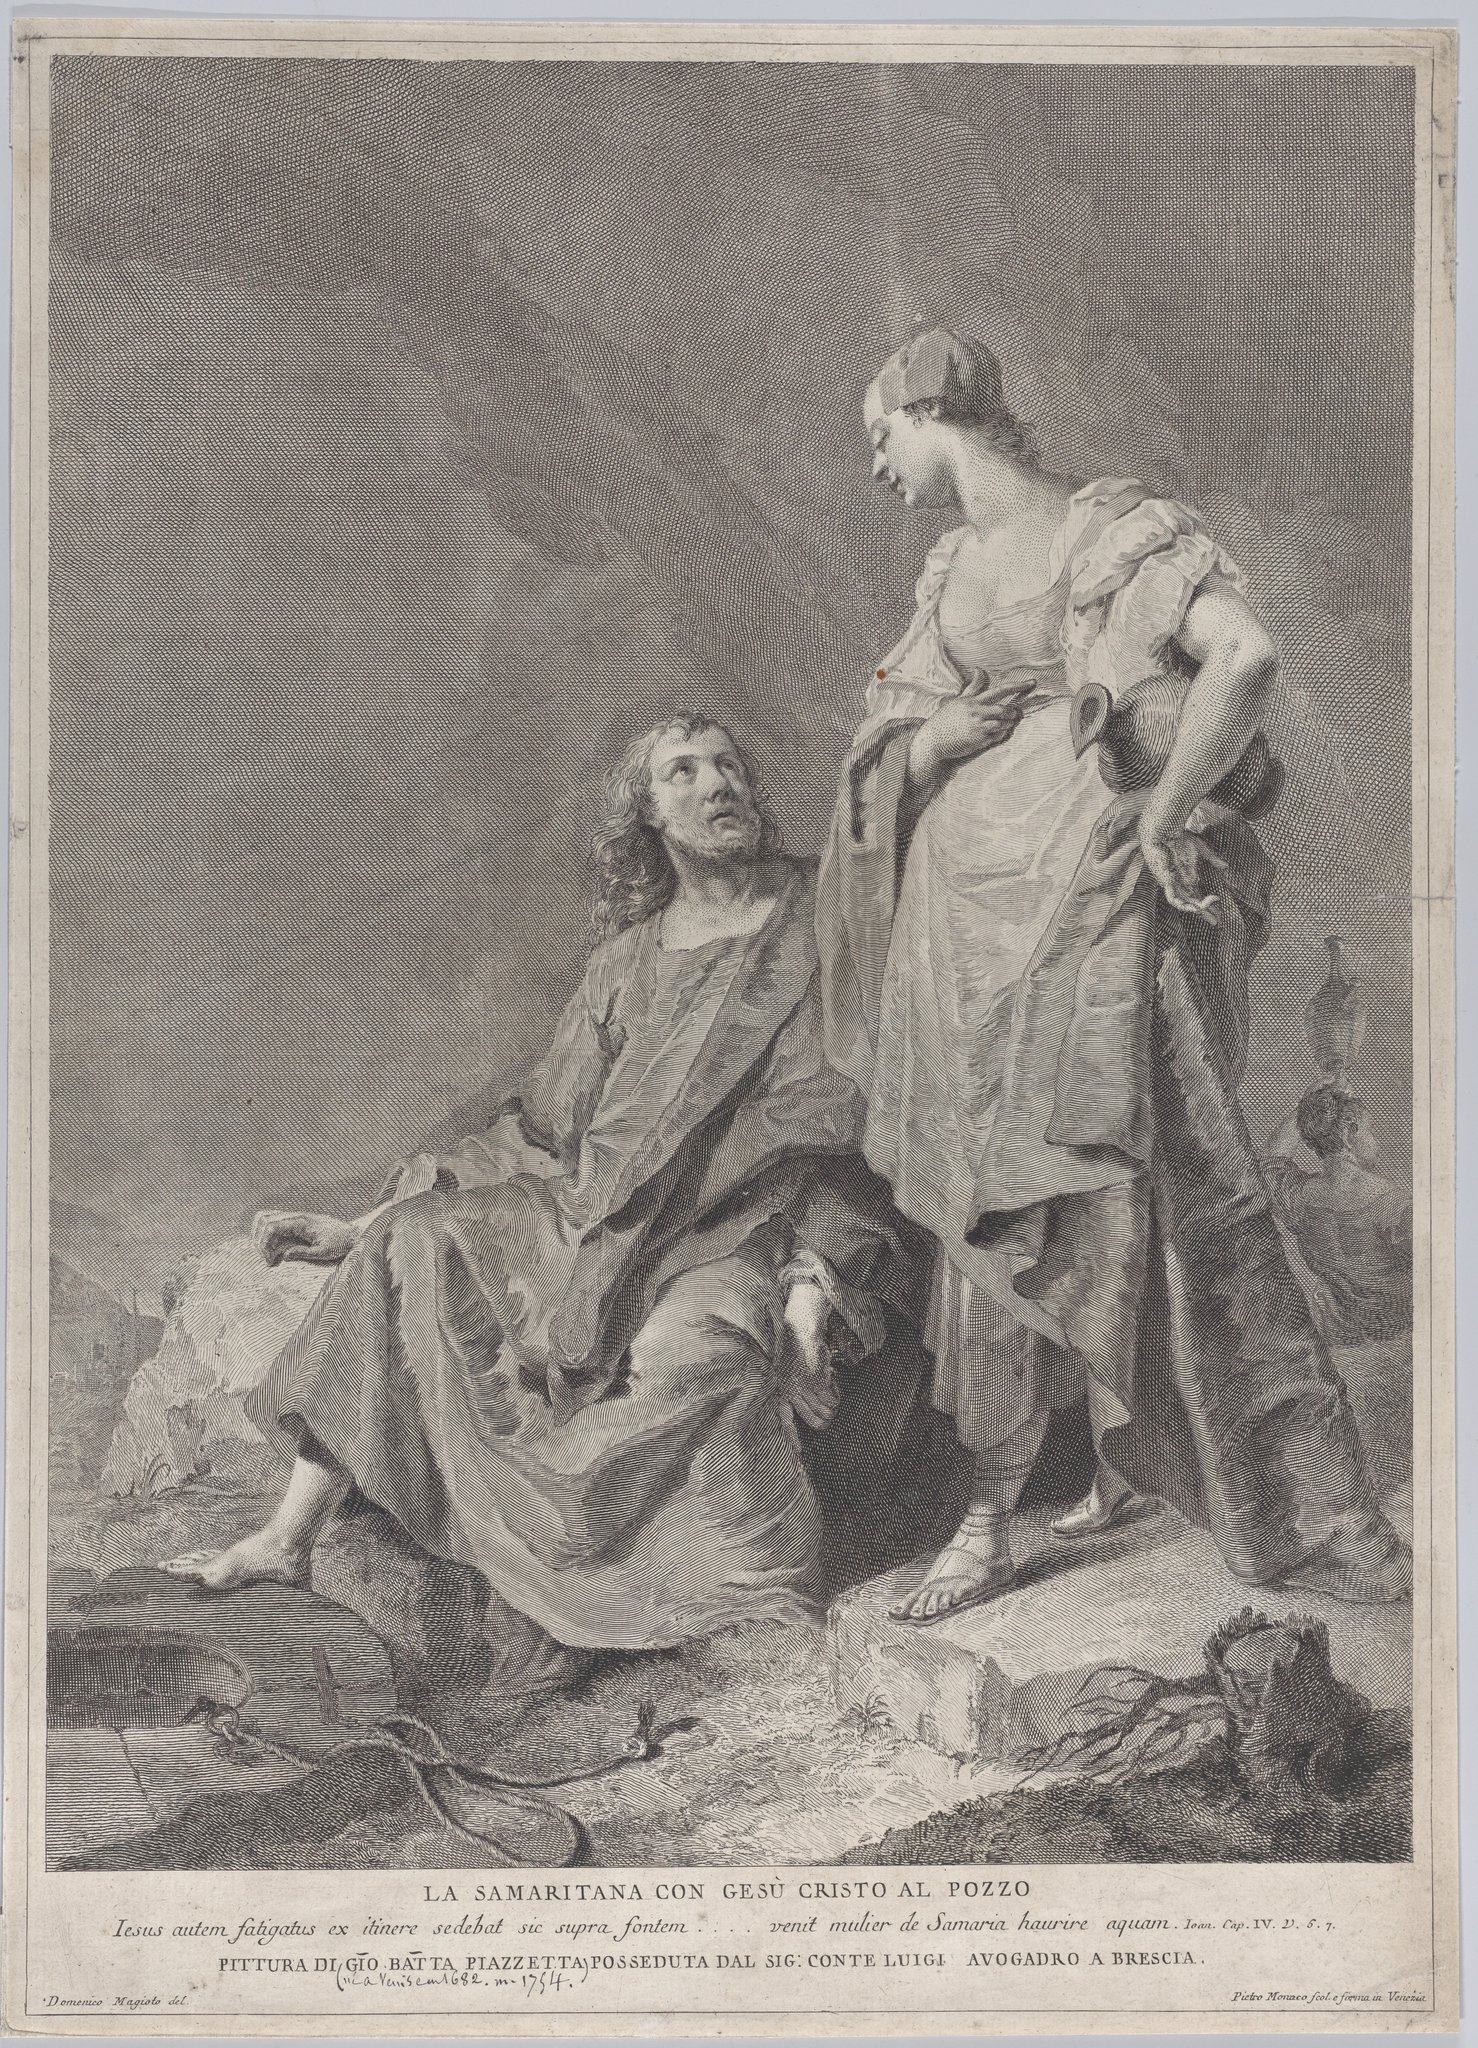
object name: print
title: Christ and the woman of Samaria at the well, from the series of 112 prints of the sacred history, after the painting by Giovanni Battista Piazzetta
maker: pietro monaco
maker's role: artist and publisher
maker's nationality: italian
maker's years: 1707-1772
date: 1743-1763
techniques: engraving, etching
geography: venice